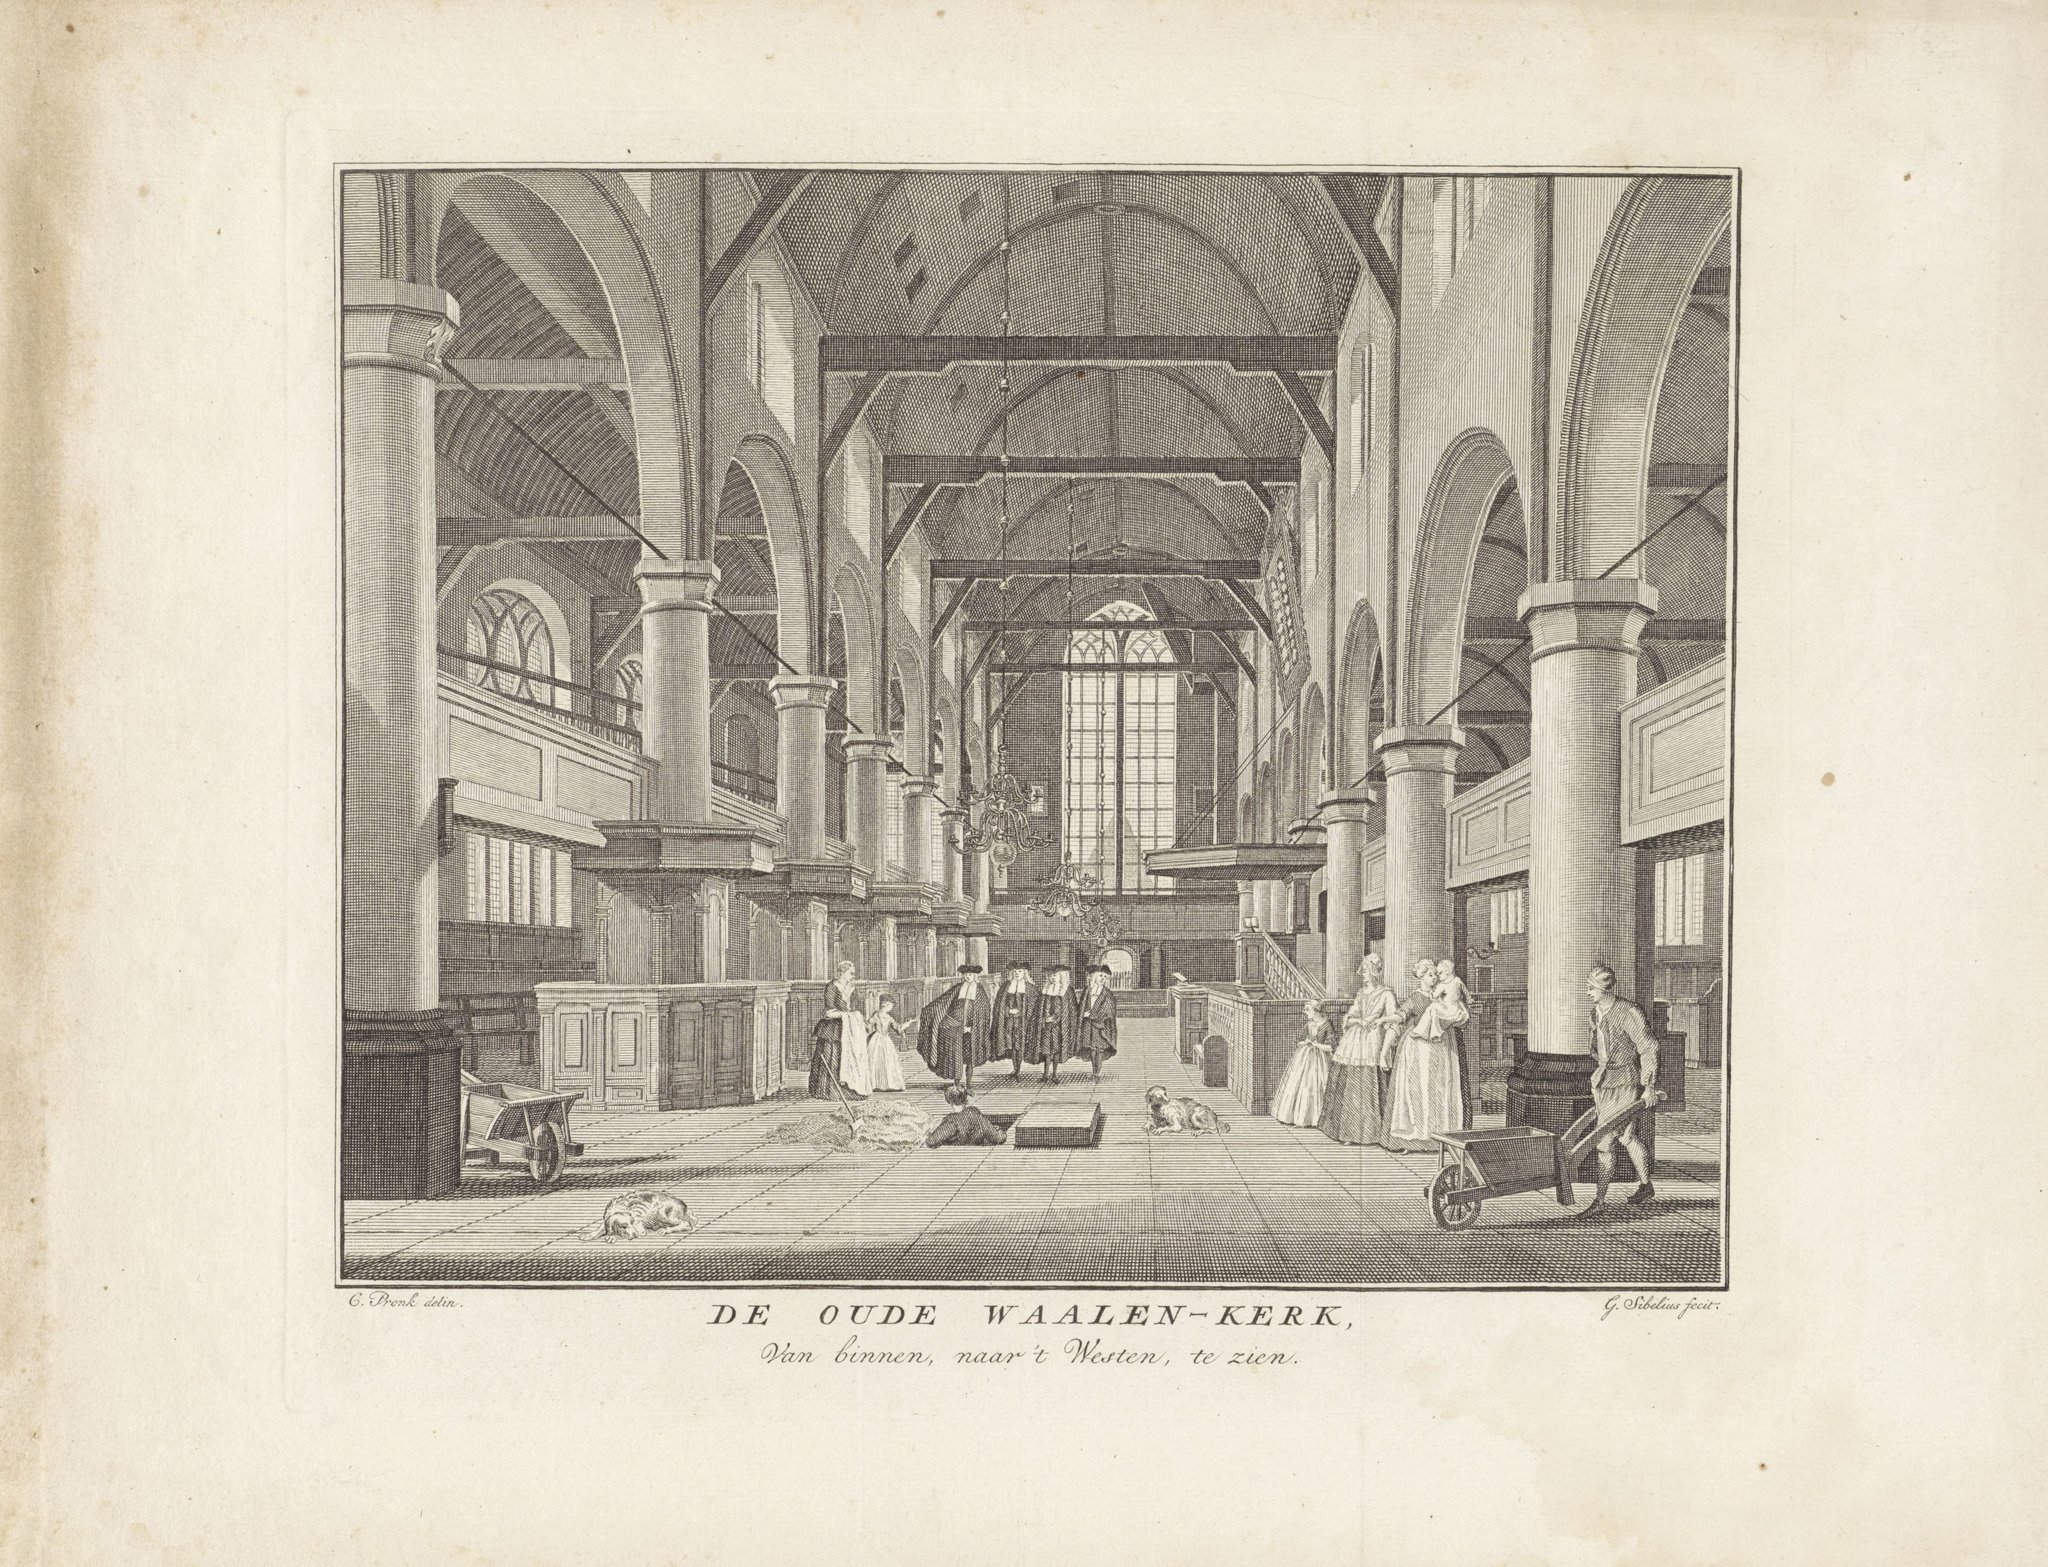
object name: print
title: De Oude Waalen-Kerk van binnen, naar 't Westen, te zien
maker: gerard sibelius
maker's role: print maker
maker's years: 1734-1785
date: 1760-1765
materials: paper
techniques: engraving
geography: netherlands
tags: hand-cart, interior of church, wheelbarrow, grave digger, dog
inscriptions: collector's mark: Lugt 2228, inscription: ‘DE OUDE WAALEN-KERK, van binnen naar 't Westen te zien .’, signature and date: ‘r.o.: G. Sibelius fecit.; l.o.: C. Pronk delin.’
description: Interieur van de Oude Waalse kerk aan de Oudezijds Achterburgwal in Amsterdam. Mensen kijken toe hoe een graf gedolven wordt. Rechts een man met een kruiwagen. Twee honden liggen op de vloer.